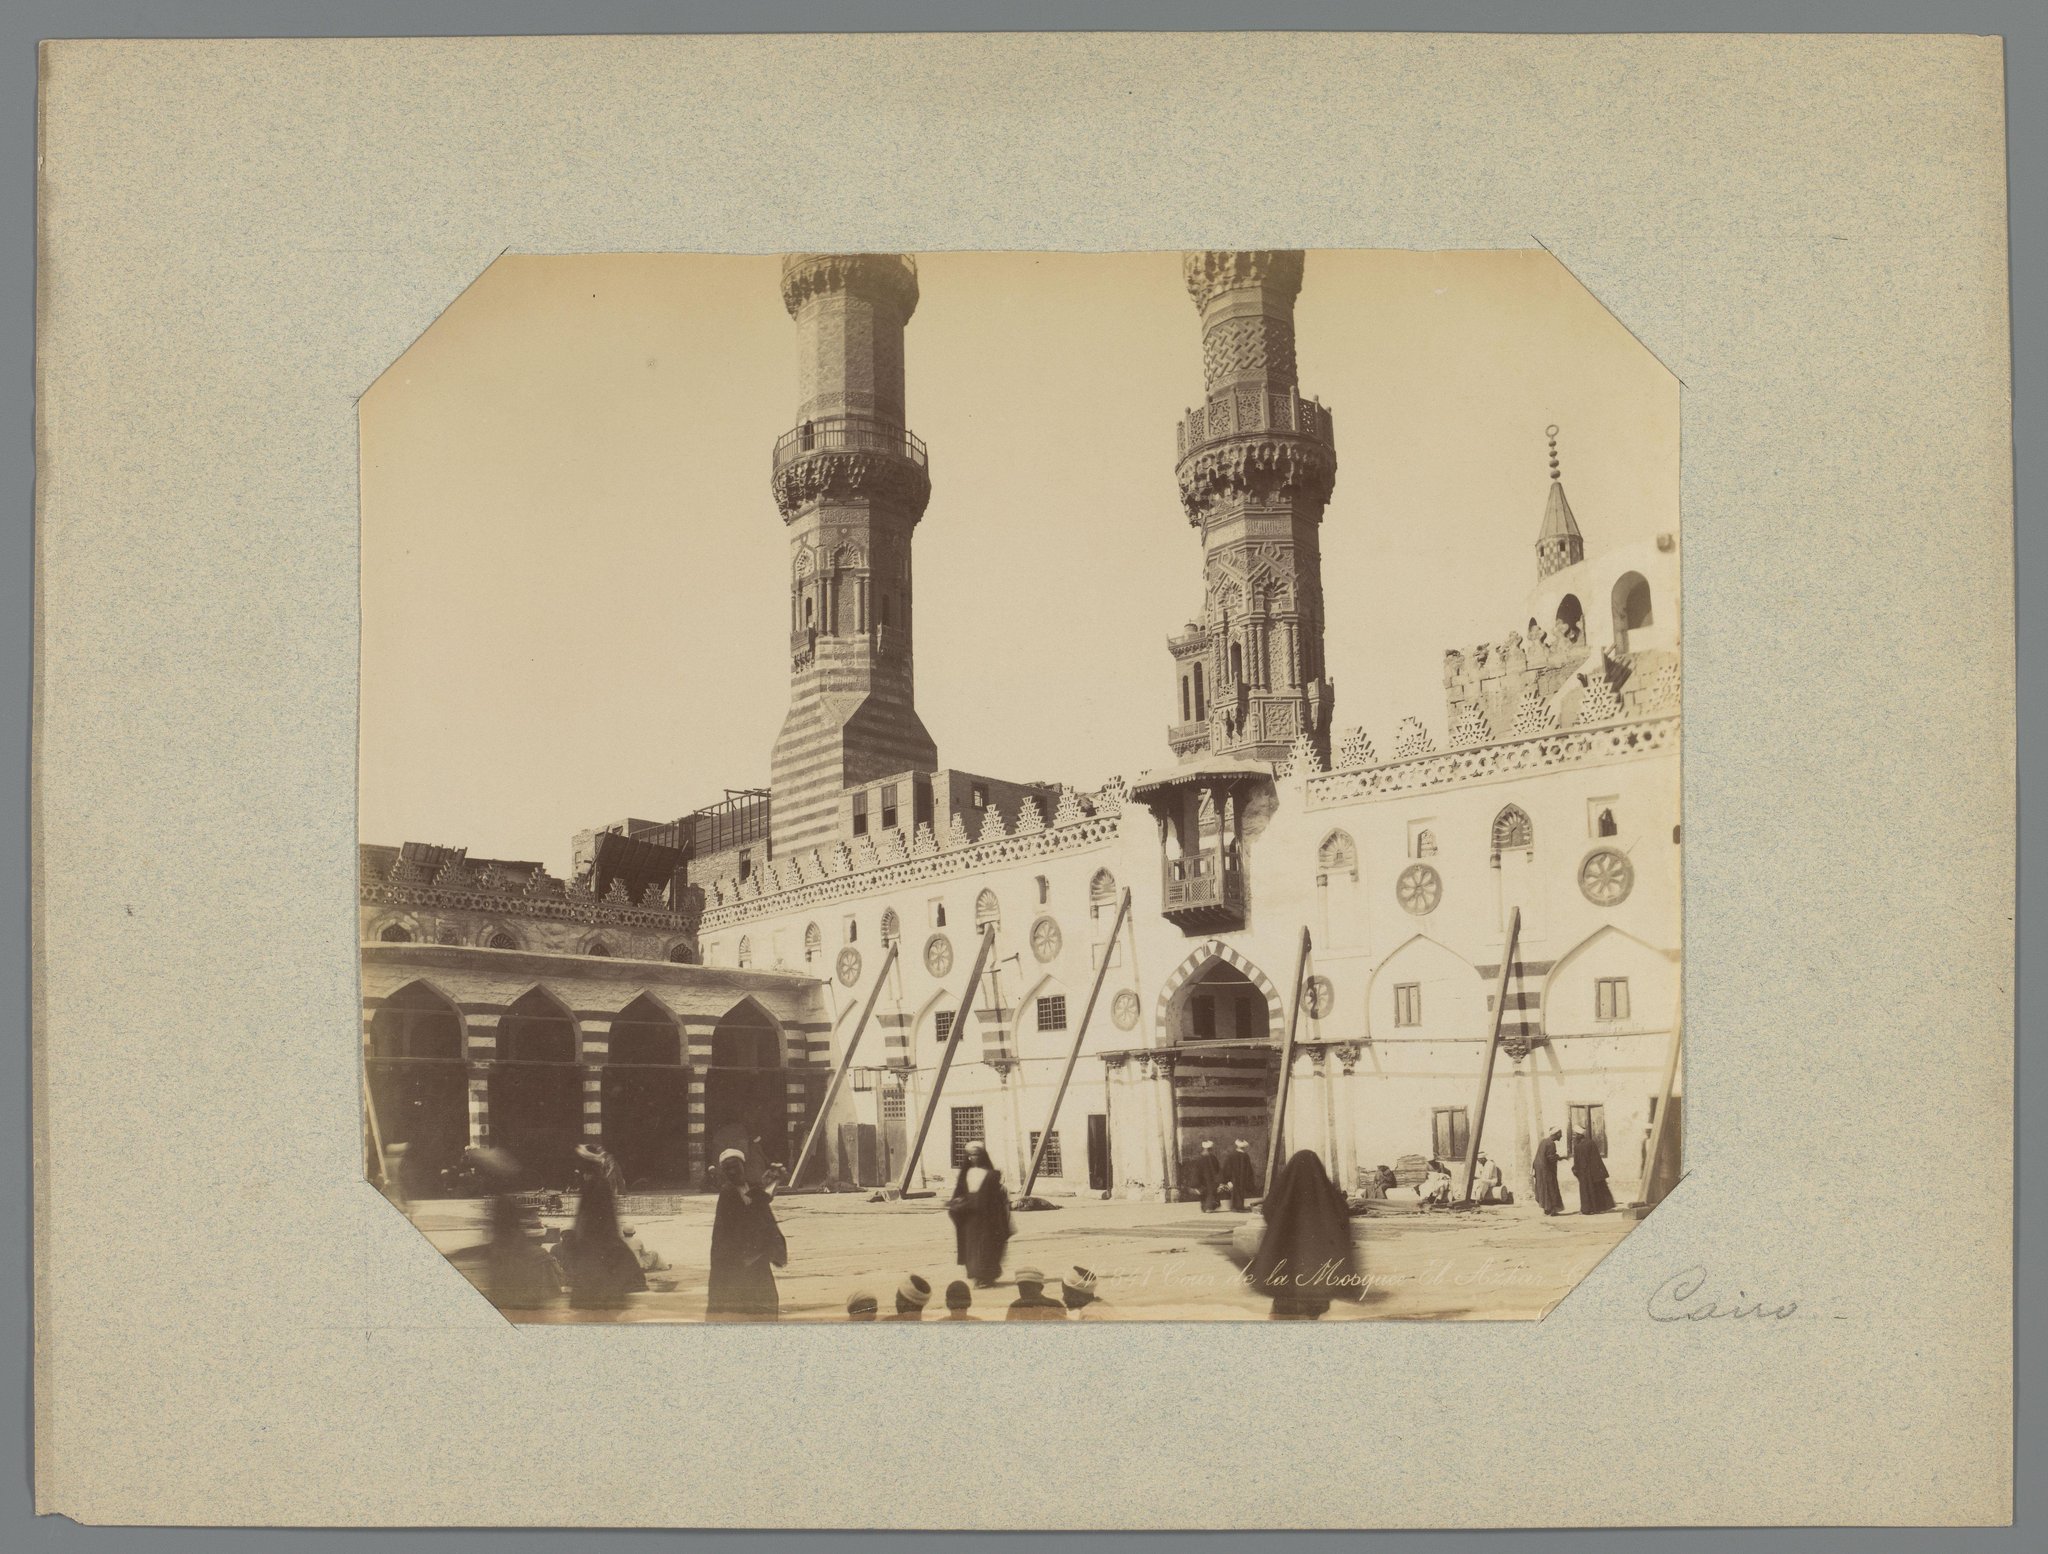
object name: photograph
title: Al-Azhar-moskee in Caïro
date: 1870-1910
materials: cardboard, paper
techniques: albumen print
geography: cairo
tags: temple, shrine ~ islam, mohammedanism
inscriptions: number: ‘No 841’